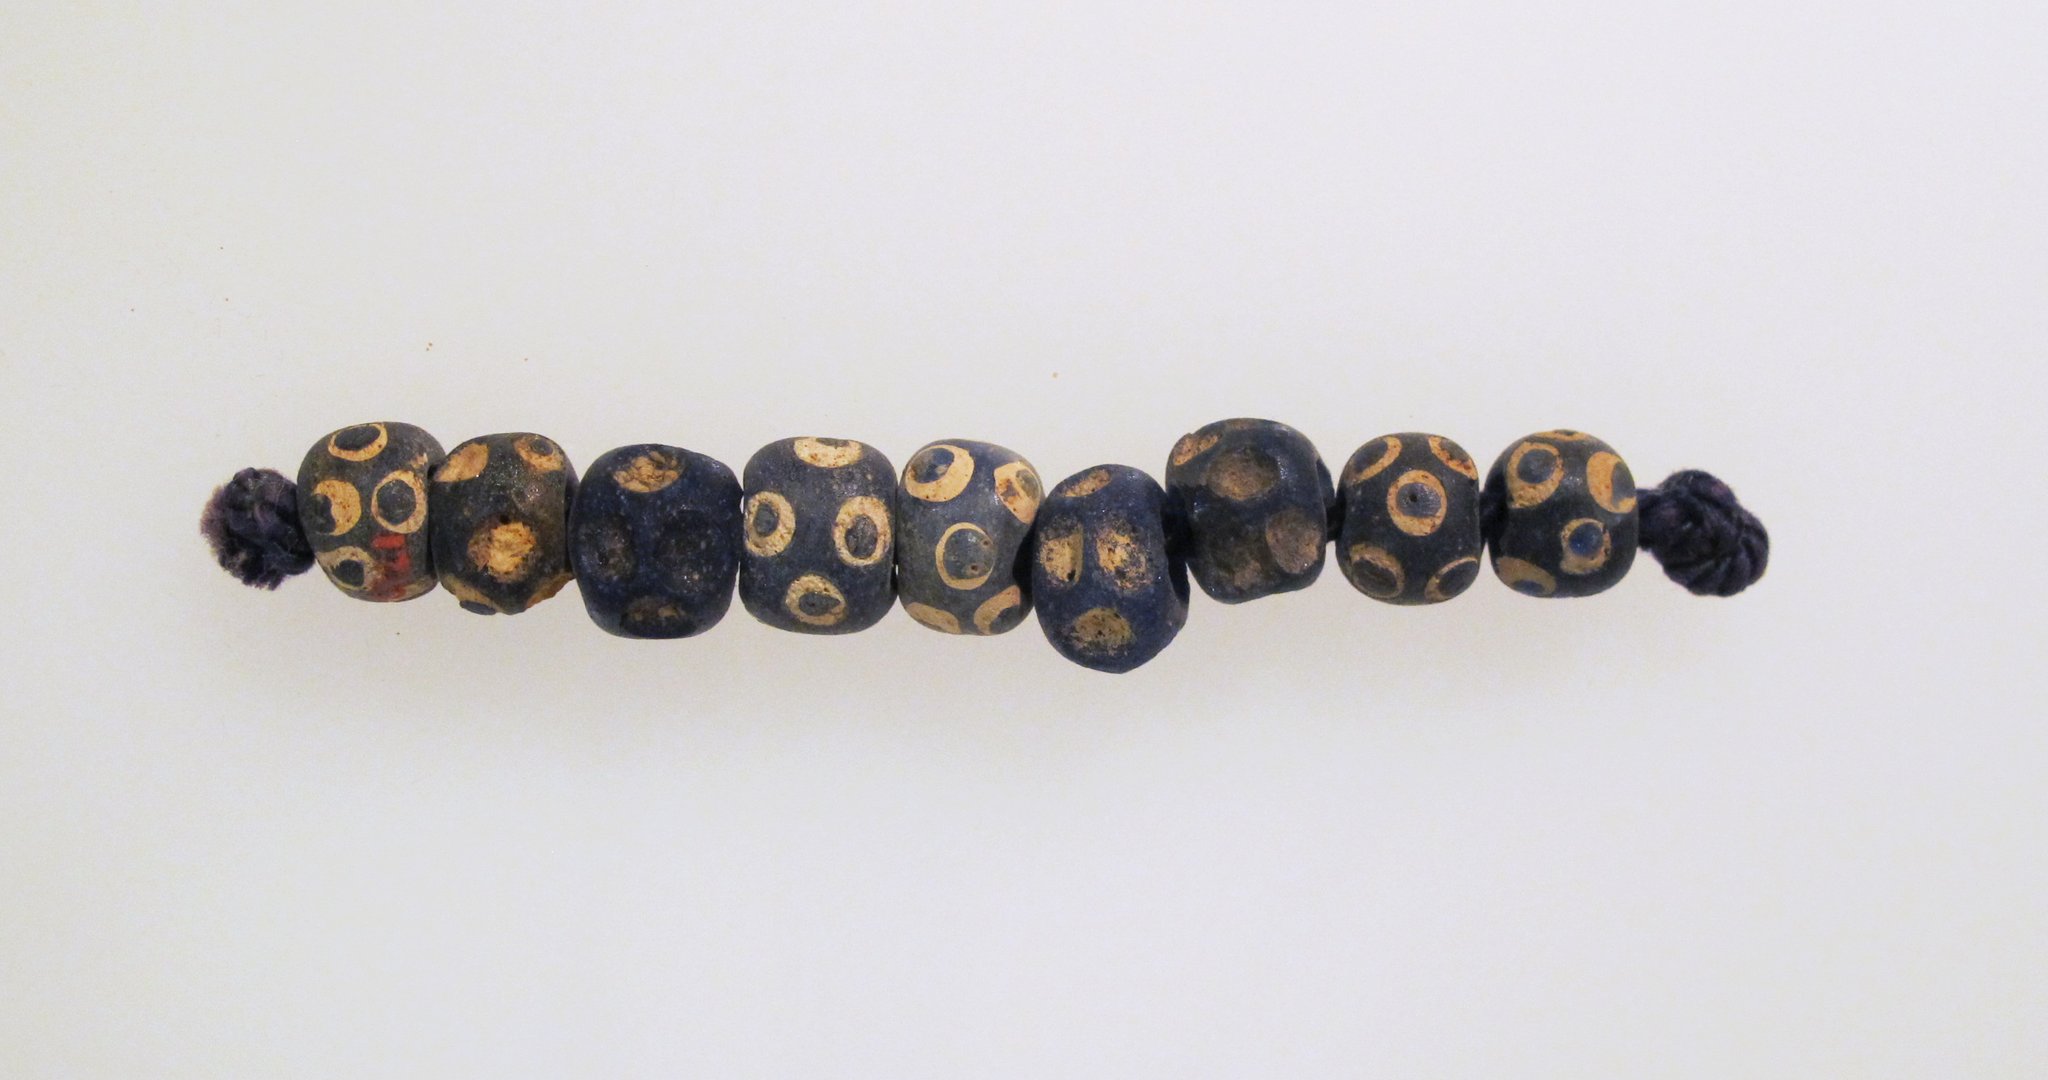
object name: bead, 9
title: Beads, 9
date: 7000 BCE-330 CE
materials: glass